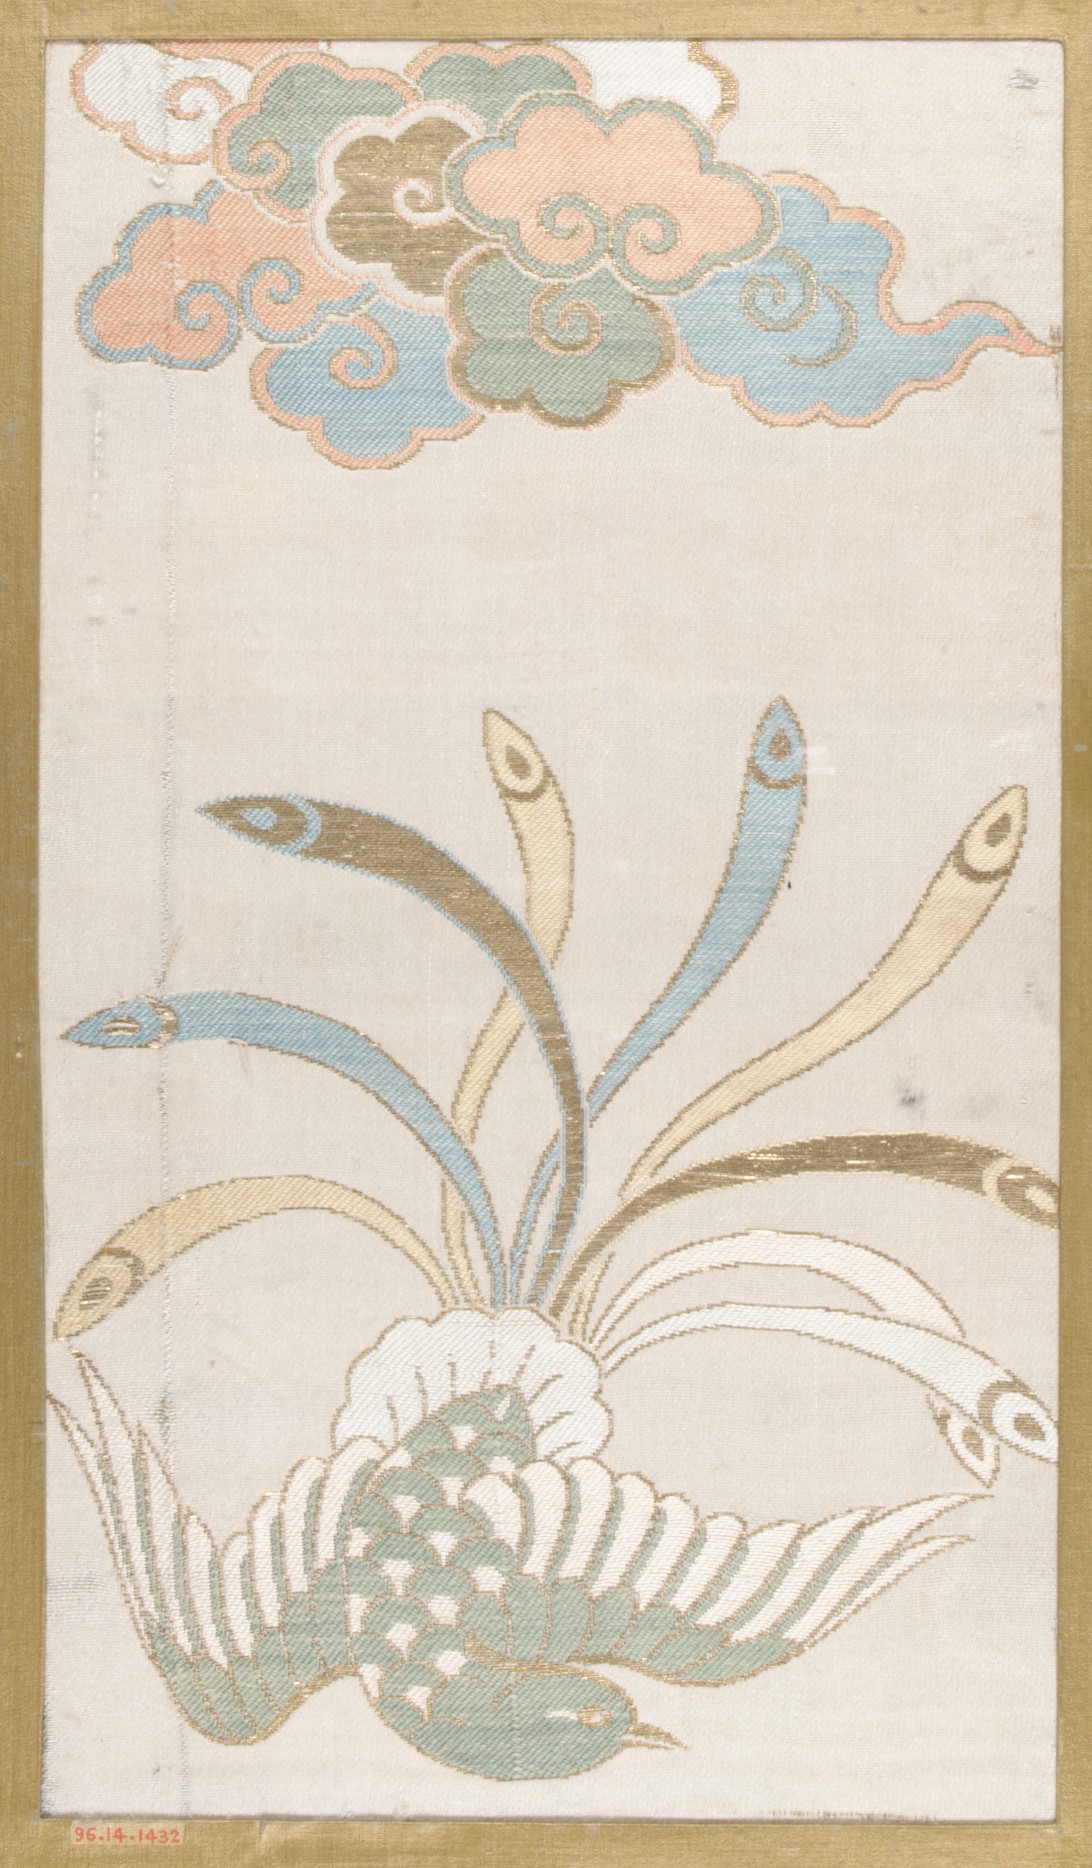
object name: piece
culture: japanese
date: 1701-1900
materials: silk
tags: birds,clouds